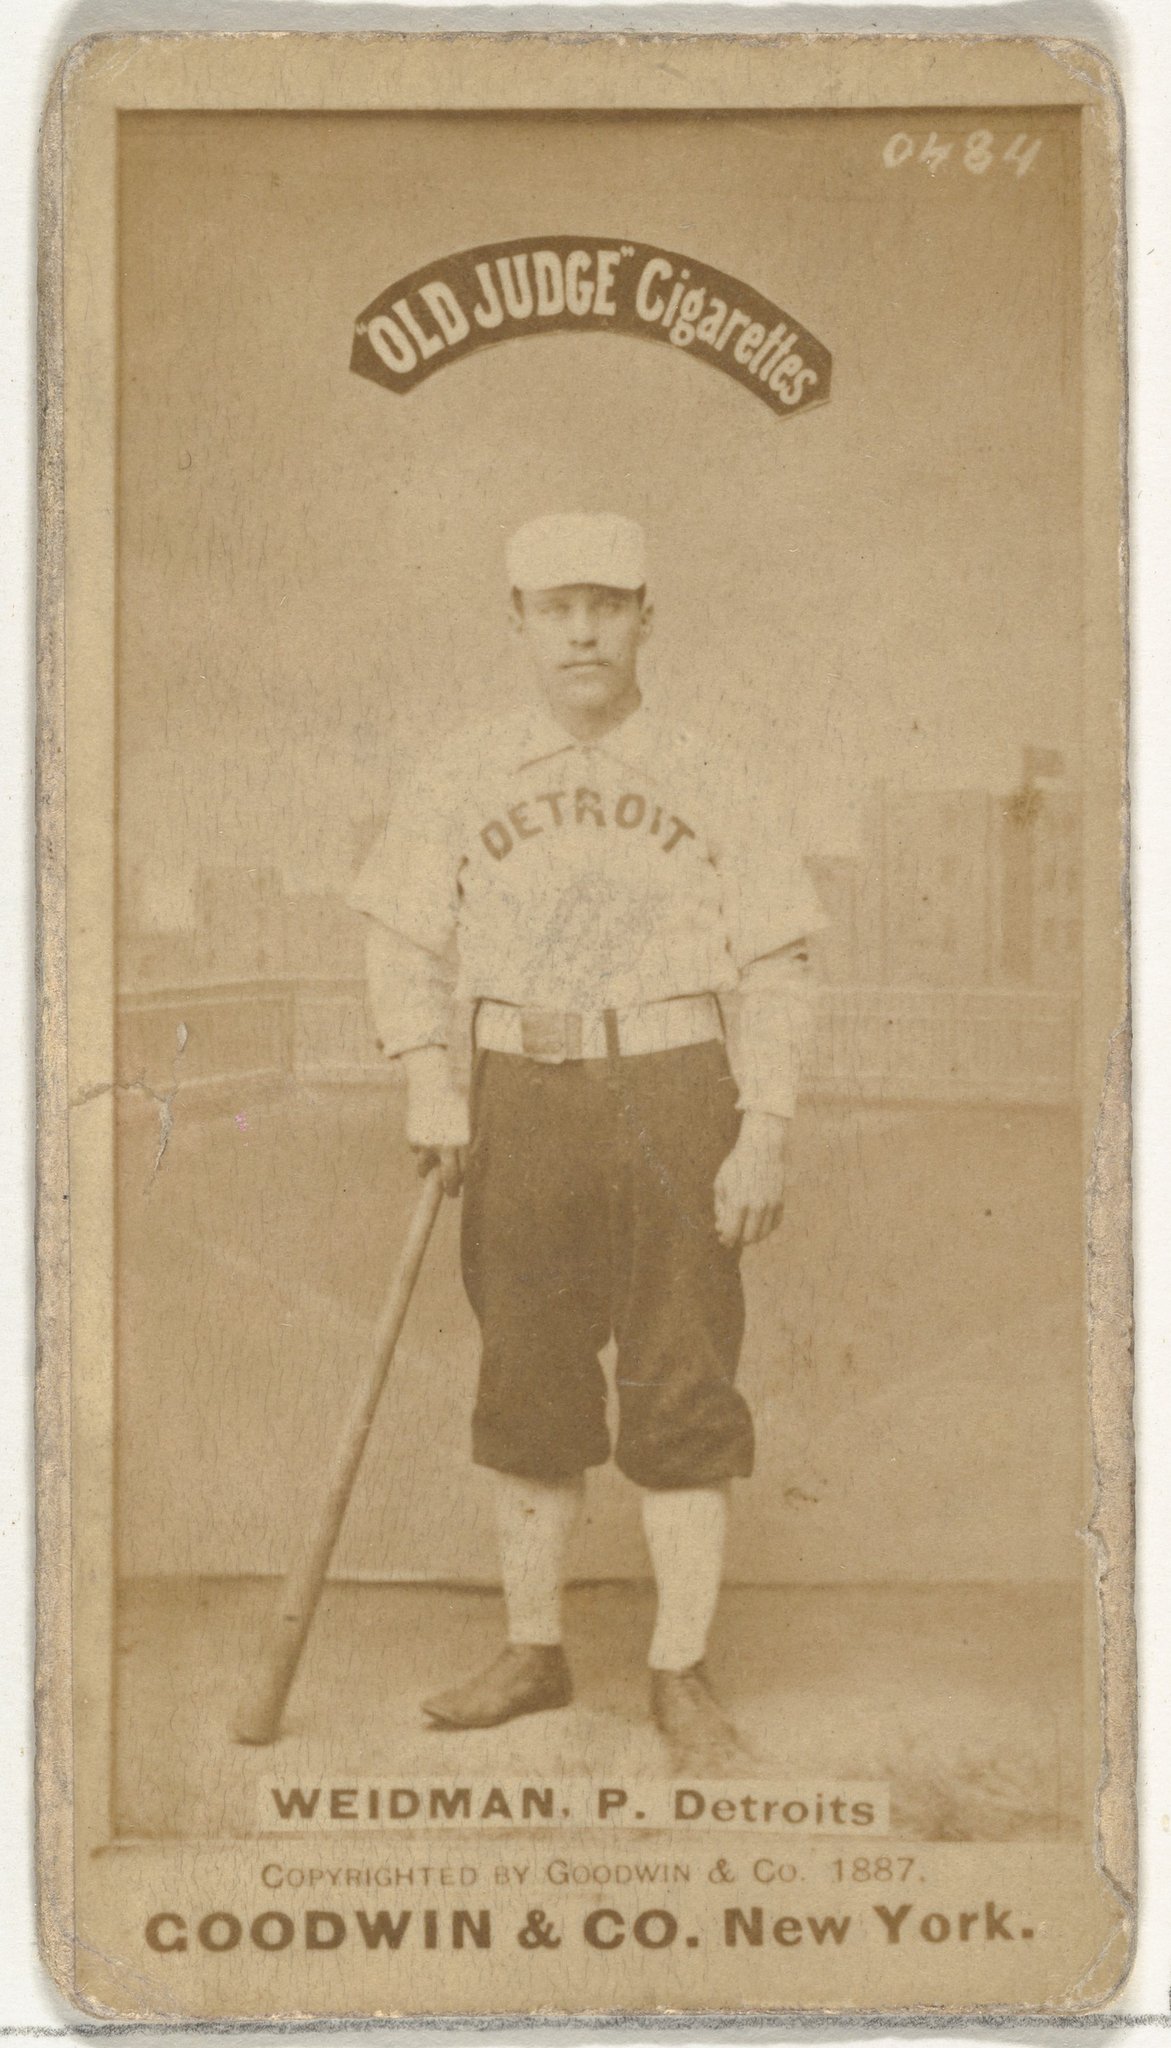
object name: baseball card, photograph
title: George Edward "Stump" Wiedman, Pitcher, Detroit Wolverines, from the Old Judge series (N172) for Old Judge Cigarettes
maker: goodwin & company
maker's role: publisher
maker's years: 1850-1950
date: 1887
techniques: albumen silver print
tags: men,portraits,baseball,athletes